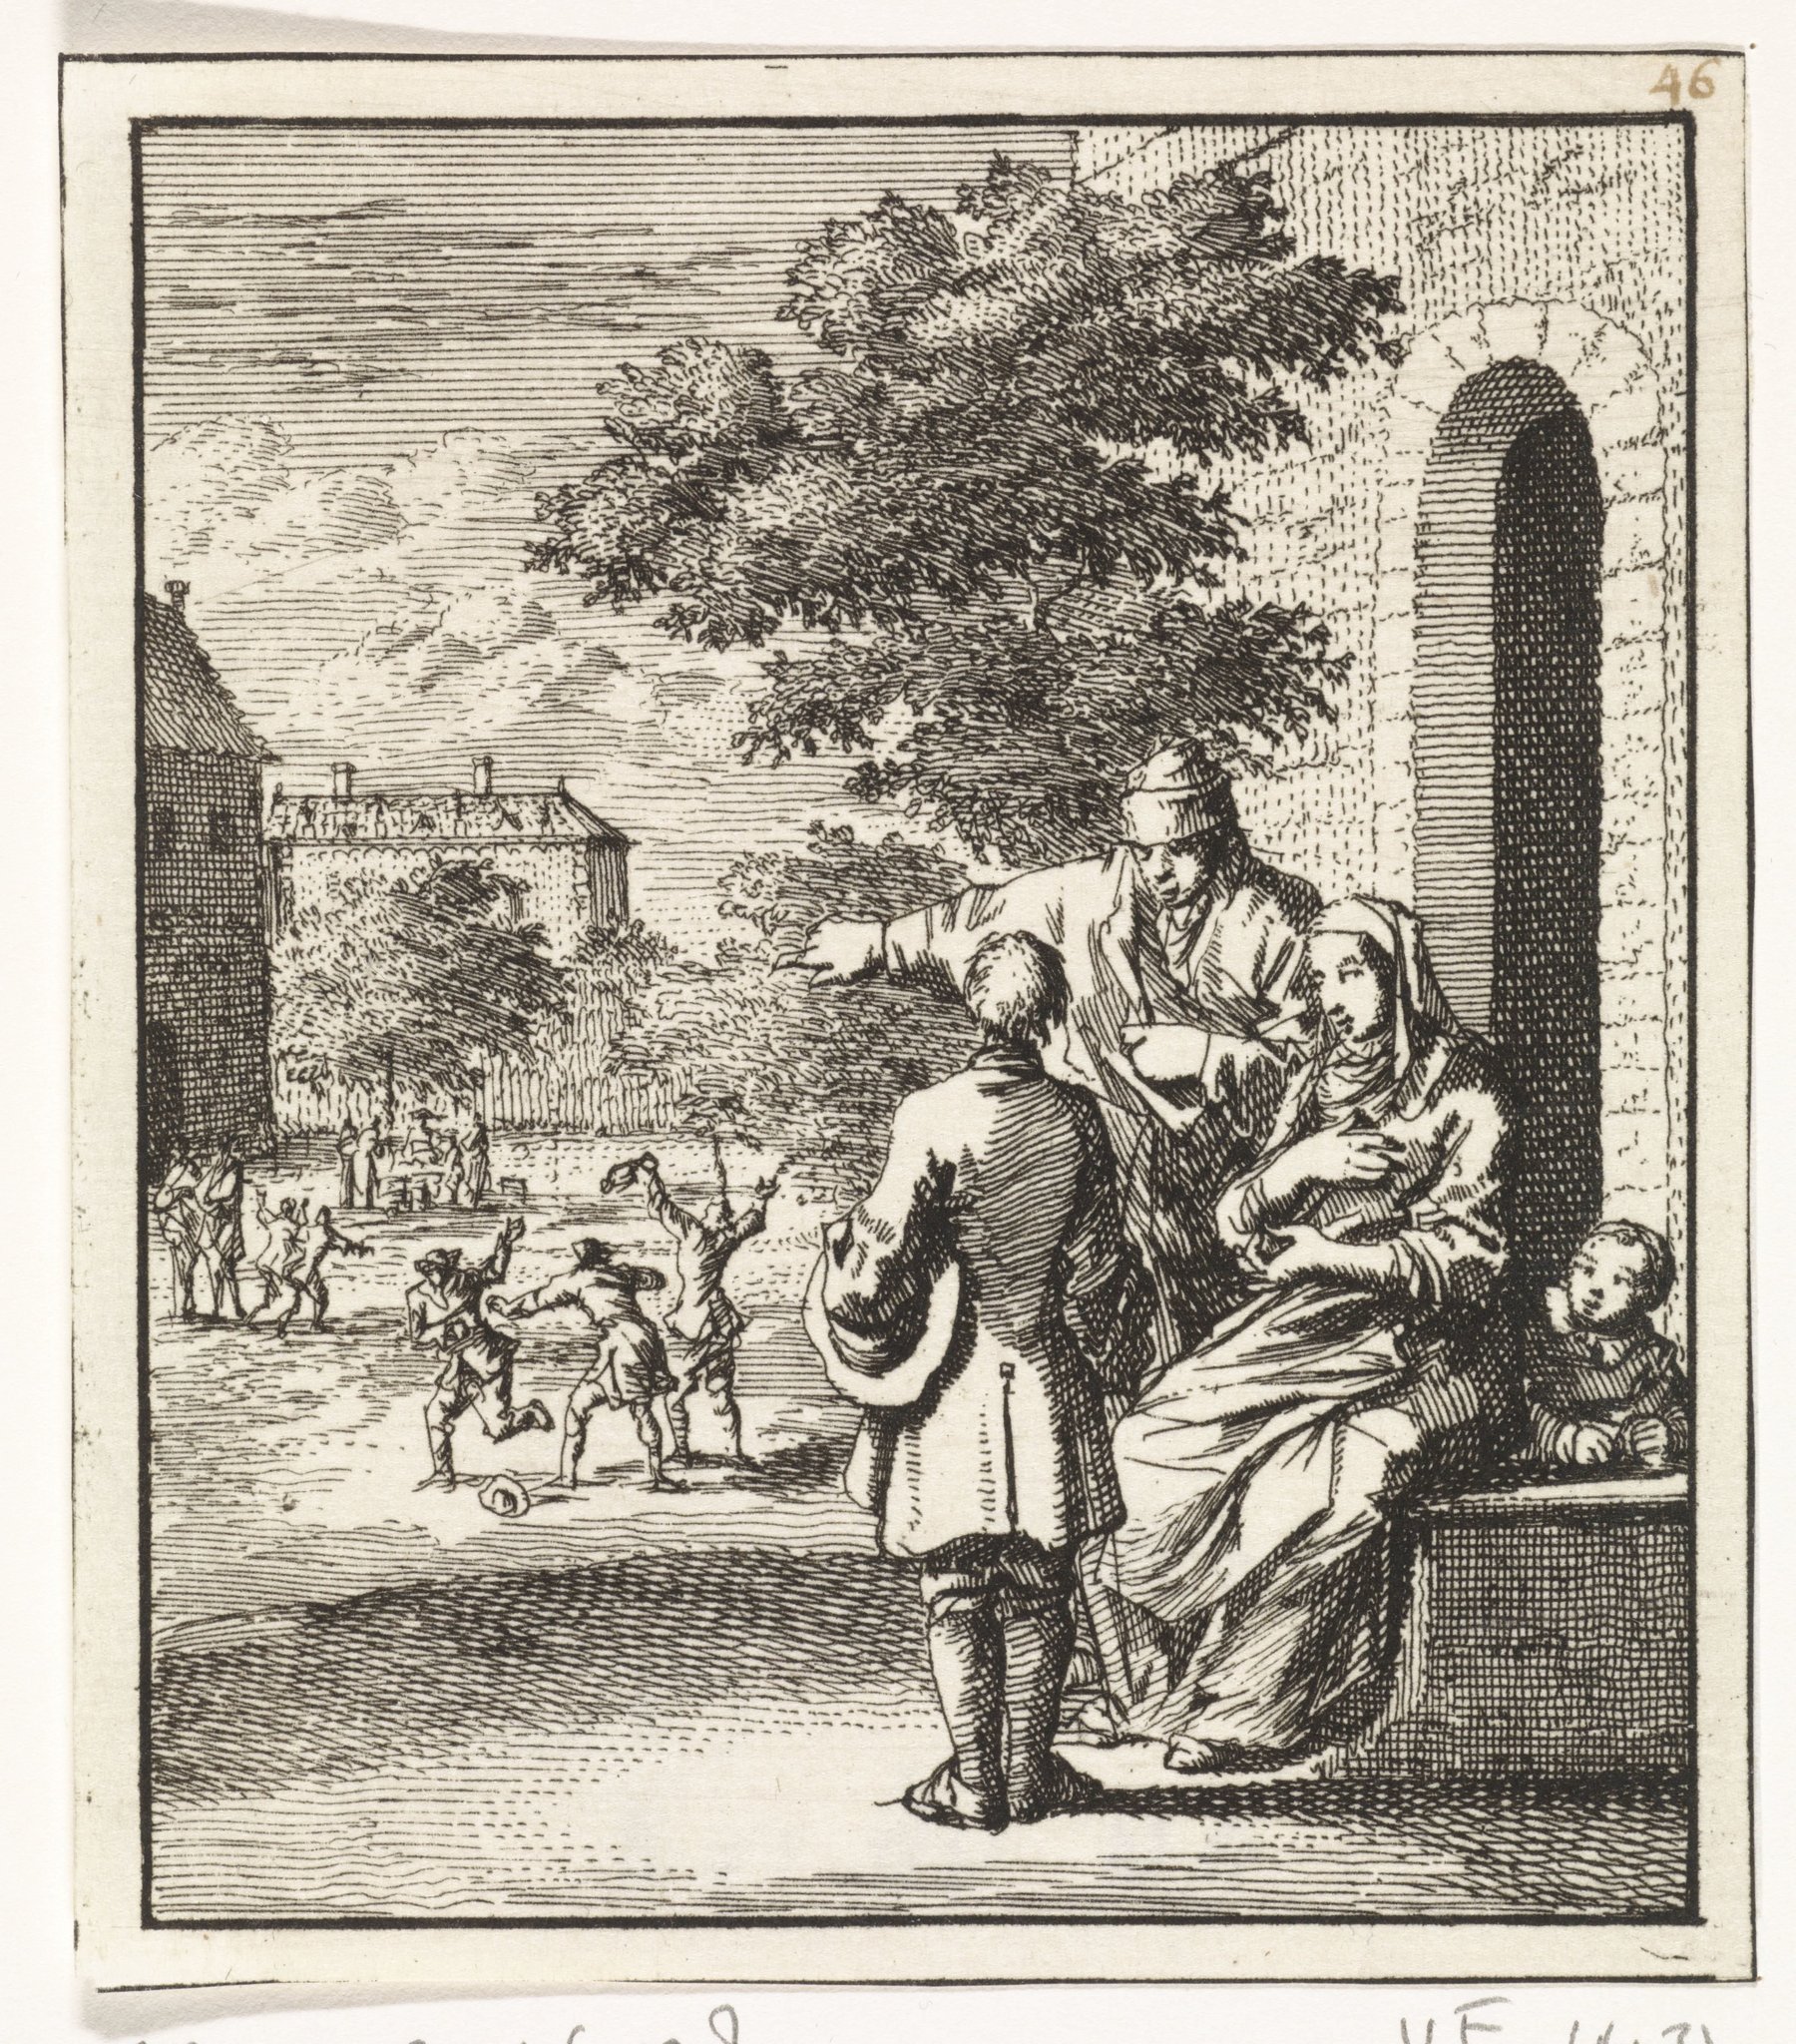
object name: print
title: De Aankomeling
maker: jan luyken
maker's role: draughtsman, print maker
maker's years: 1649-1712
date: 1712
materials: paper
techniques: etching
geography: amsterdam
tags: children's games and plays, index finger forwards, pointing, indicating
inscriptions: number: ‘46’, collector's mark: Lugt 2228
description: Proefdruk van illustratie uit: Luyken, Jan. Des menschen begin, midden en einde. Amsterdam: Wed. Pieter Arentsz II en Cornelis van der Sys, 1712, p. 95.